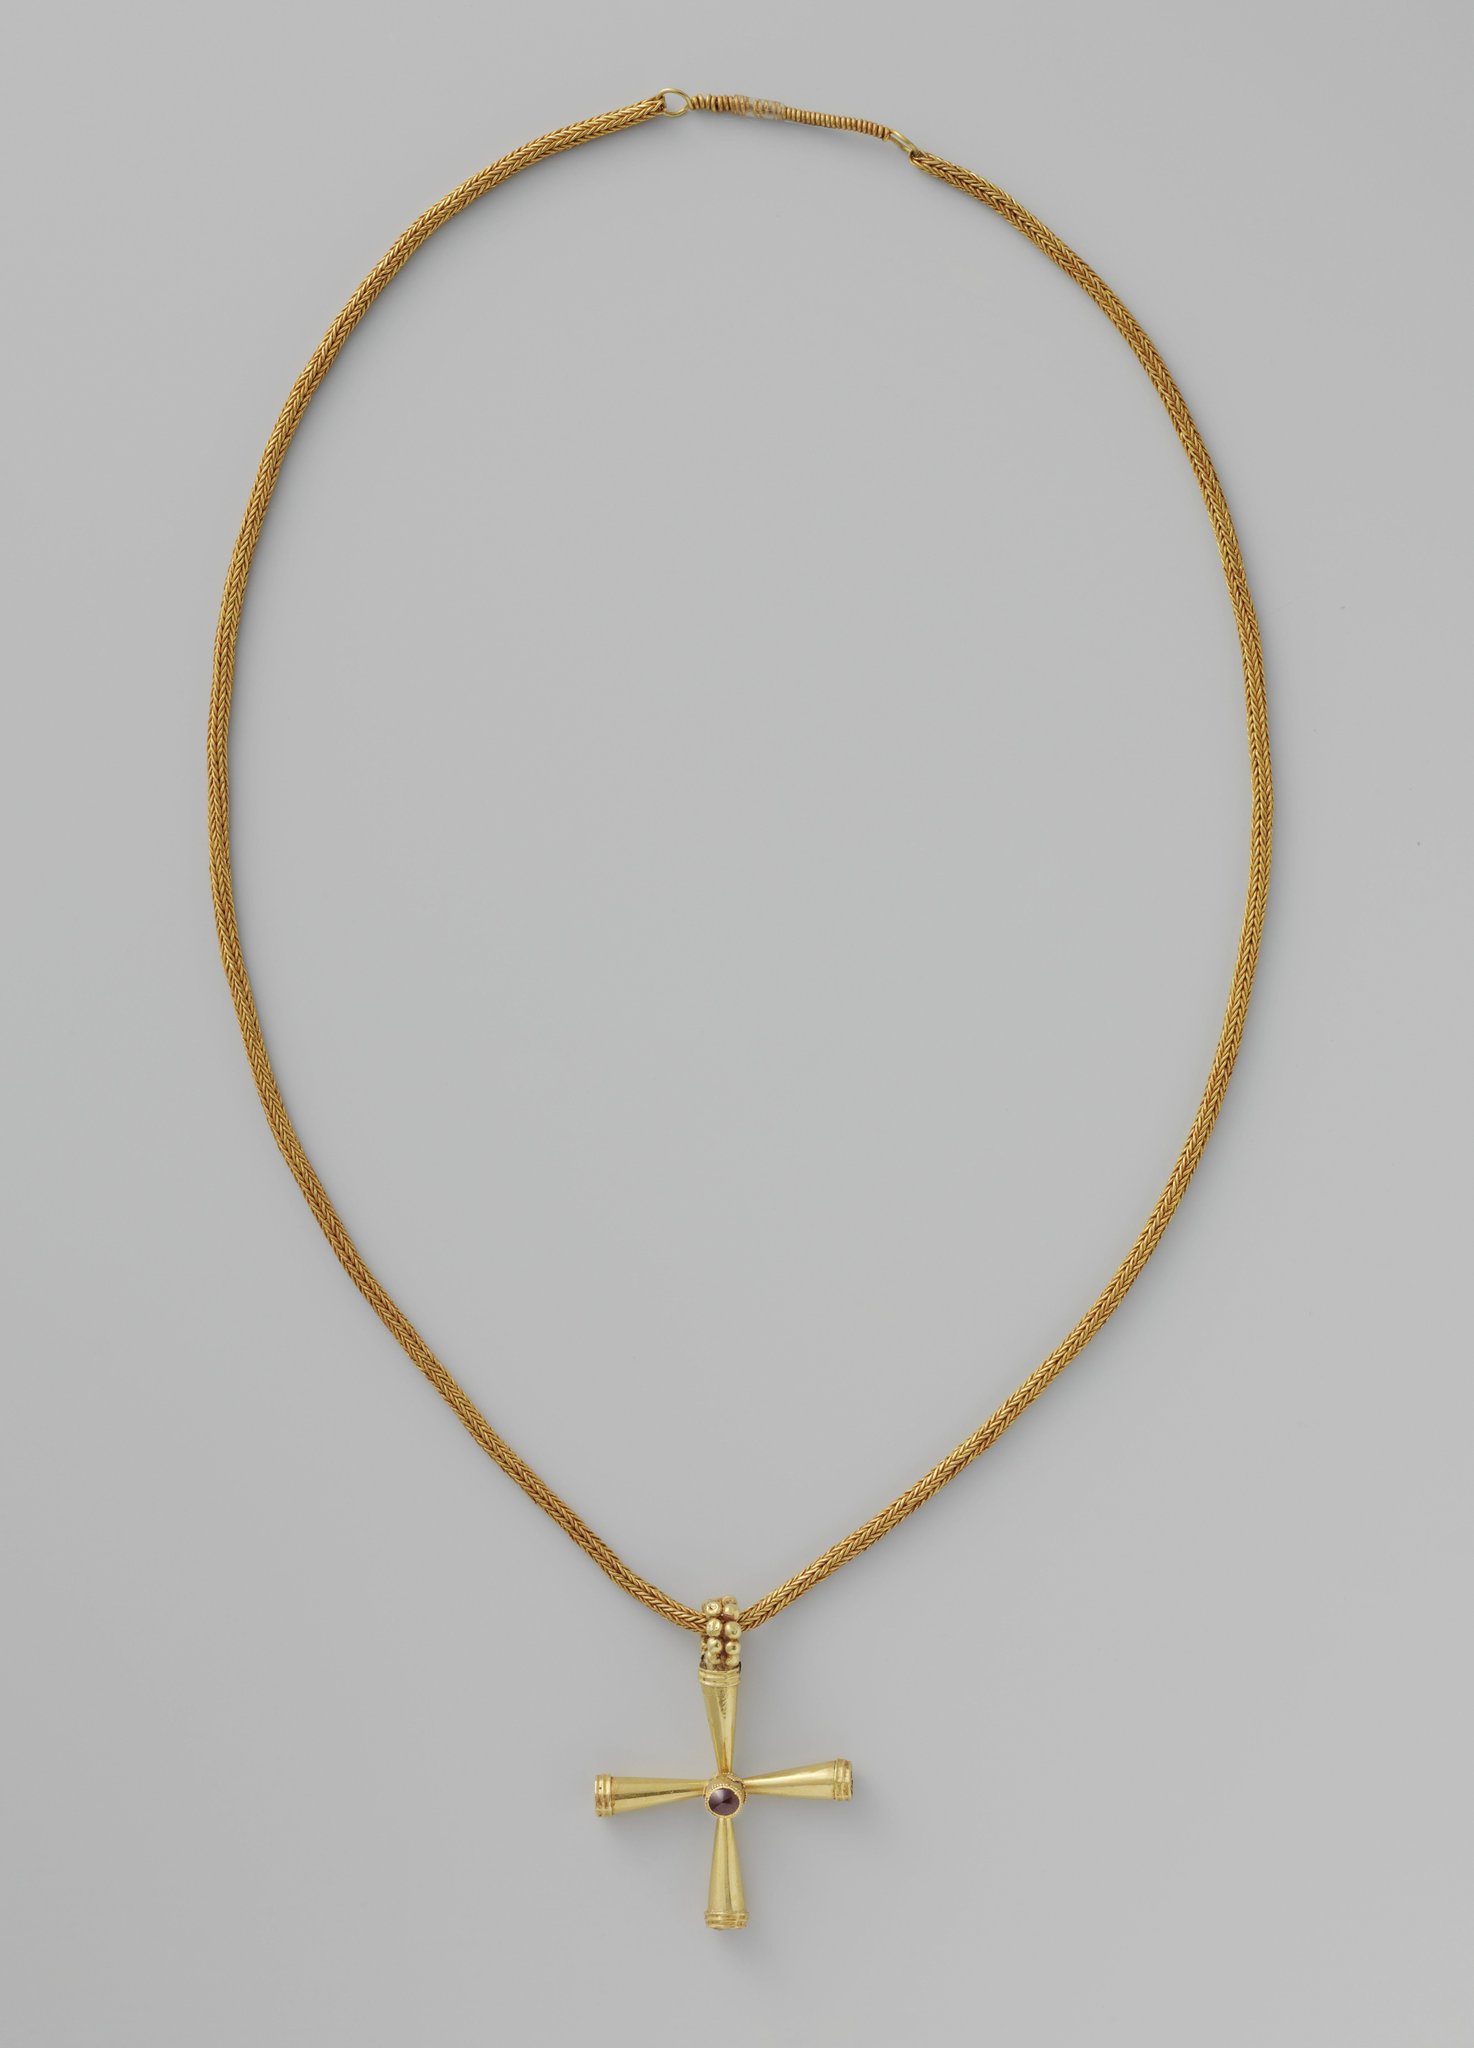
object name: necklace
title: Necklace with a cross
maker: Anonymous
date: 500-700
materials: gemstone, gold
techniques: filigree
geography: syria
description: Cross-shaped pendants began to appear soon after Christianity became the dominant religion in the Byzantine Empire. This sumptuous example affords an impression of the various techniques then in use. A particularly important role was played by gold filigree – the crafting of fine wire and beads of gold. Here there is filigree decoration on the intersection and the ends of the arms of the cross, which hangs from a chain of plaited gold wire.